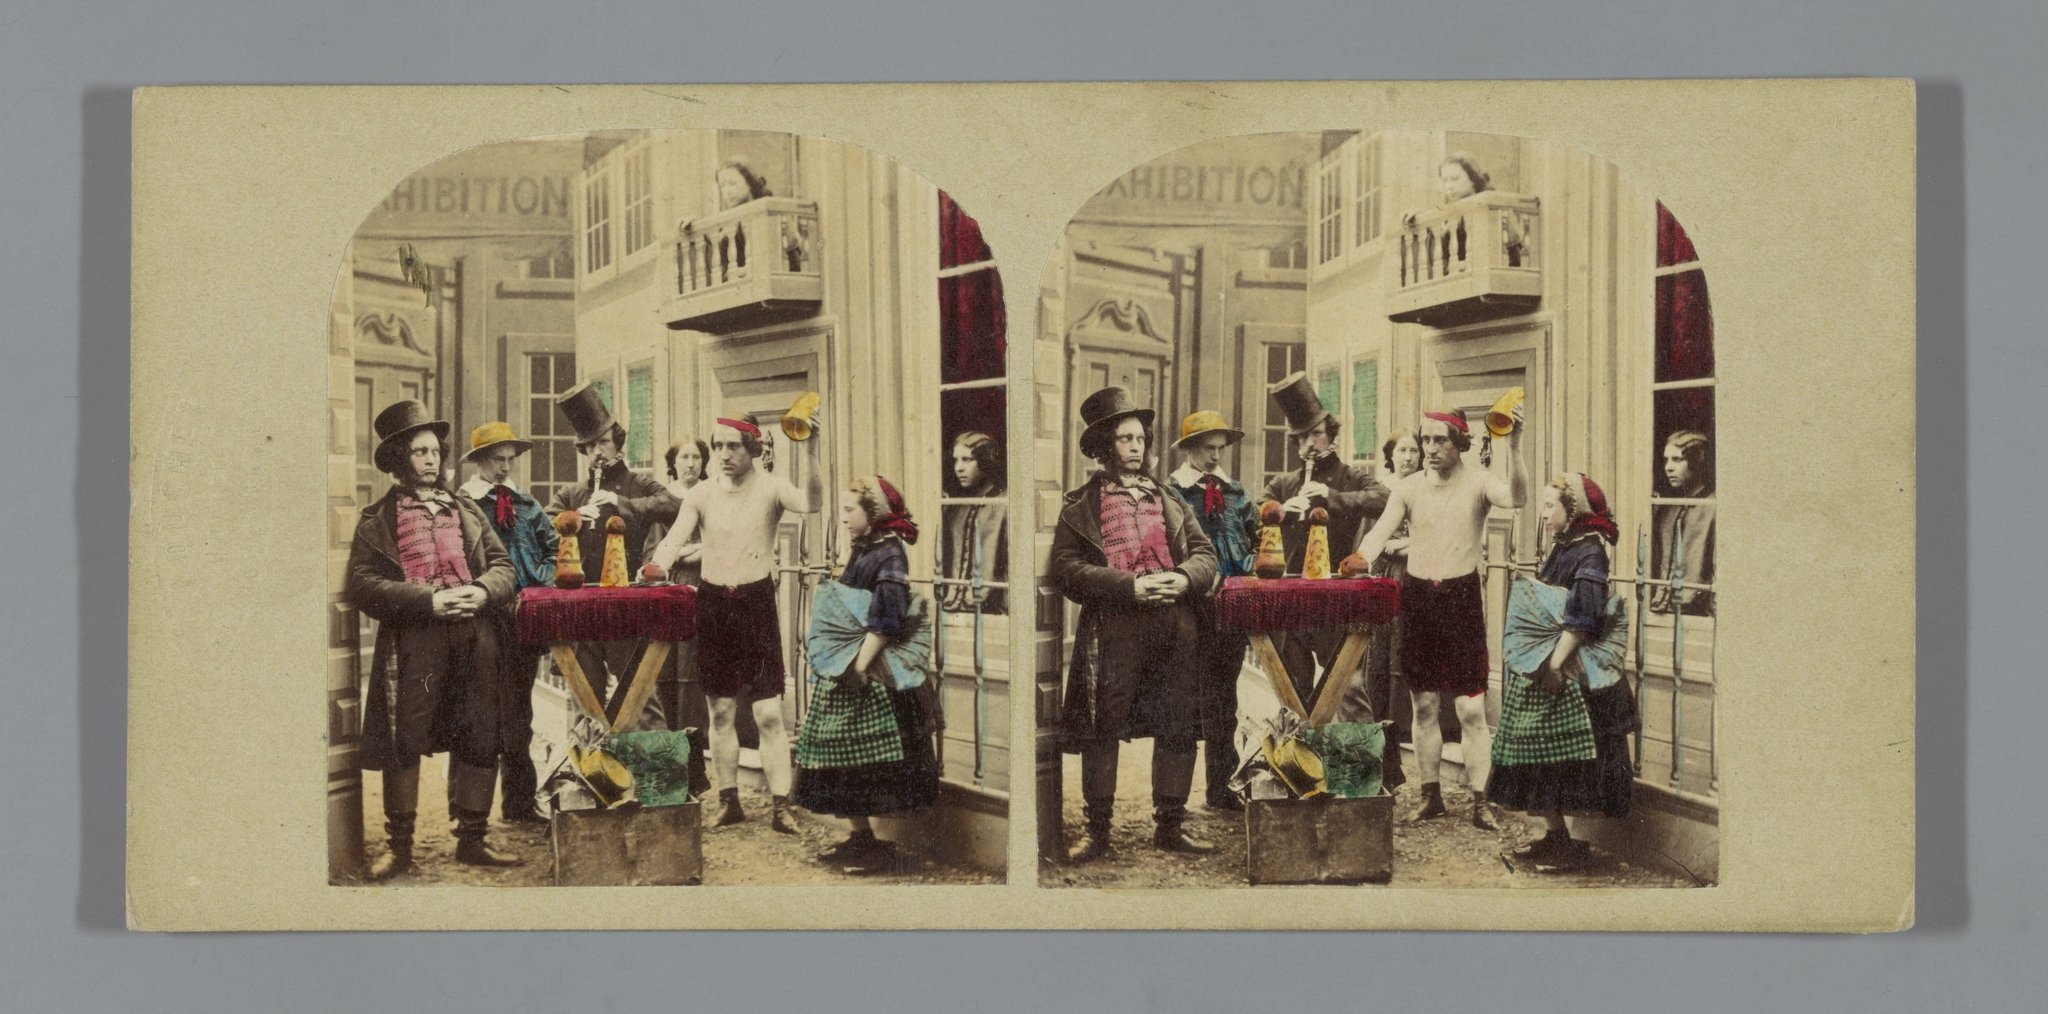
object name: stereograph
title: Goochelaar op straat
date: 1852-1863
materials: cardboard, paper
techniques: albumen print, hand coloring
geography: paris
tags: illusionist, conjurer, juggler, 'legerdemain'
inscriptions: inscription: ‘C. F:’